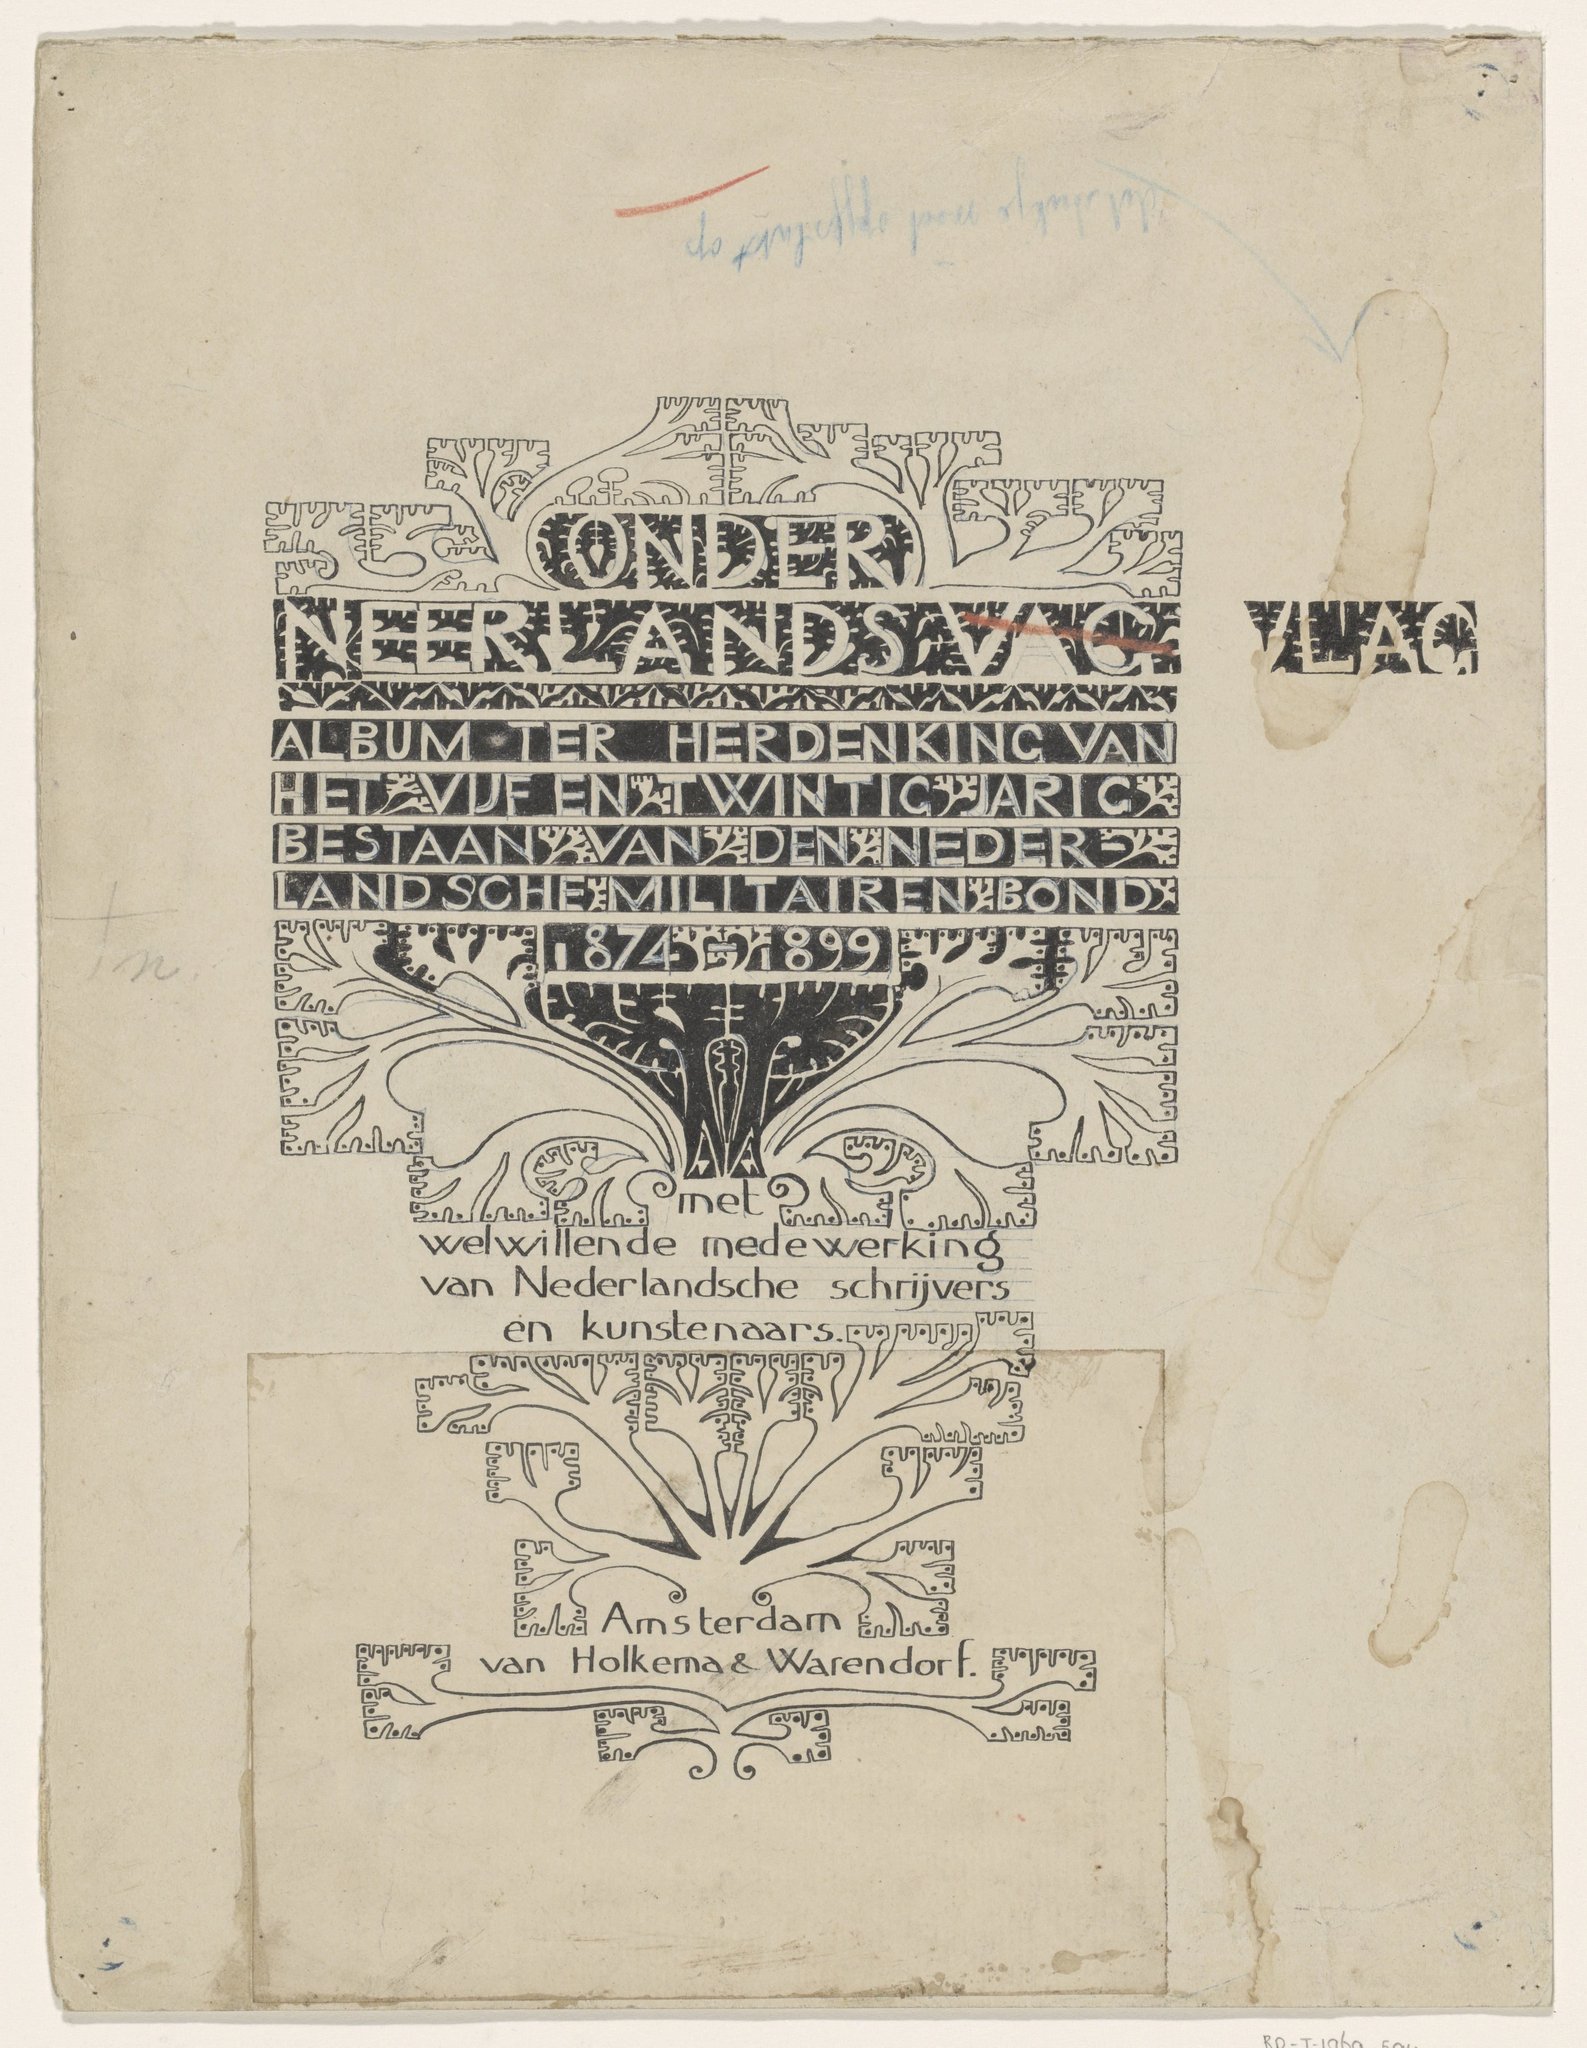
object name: drawing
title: Ontwerp voor boekband van Onder Neerlands Vlag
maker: carel adolph lion cachet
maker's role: draughtsman, print maker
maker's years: 1864-1945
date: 1874-1945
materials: cardboard, ink, pencil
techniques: brush, pen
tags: (onder neerlands vlag) specific works of literature (with author, title), book-cover, binding